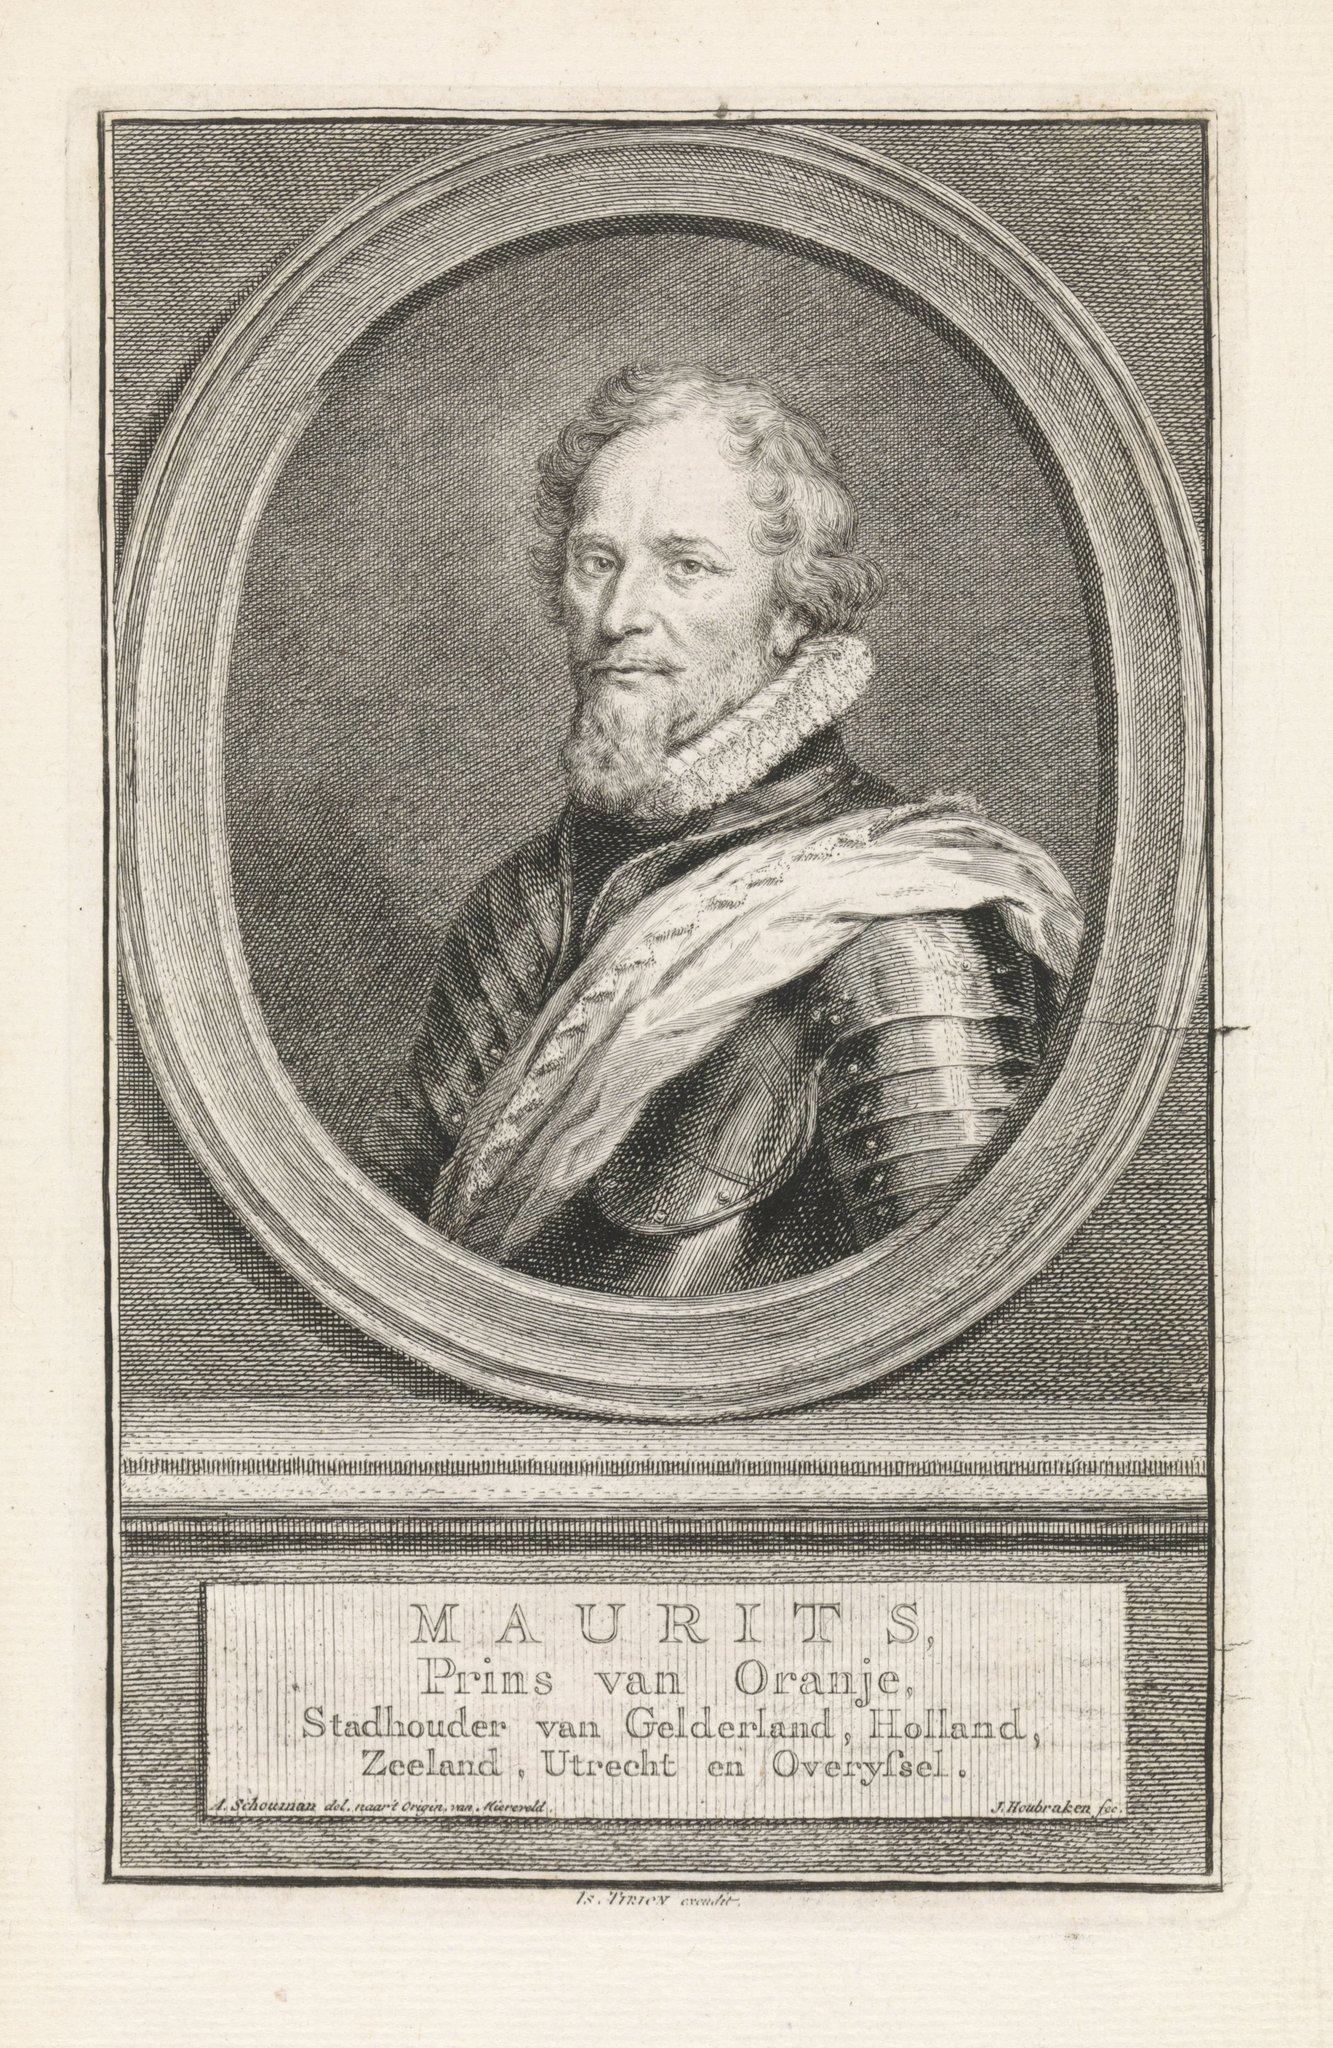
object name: print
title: Maurits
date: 1749-1759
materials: paper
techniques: engraving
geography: amsterdam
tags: maurice (prince of orange)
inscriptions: collector's mark: Lugt 2228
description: Prent ook gebruikt in: Jan Wagenaar, Vaderlandsche historie, vervattende de geschiedenissen der nu Vereenigde Nederlanden, inzonderheid die van Holland (...), 21 delen. Amsterdam, Isaak Tirion, 1749-59.